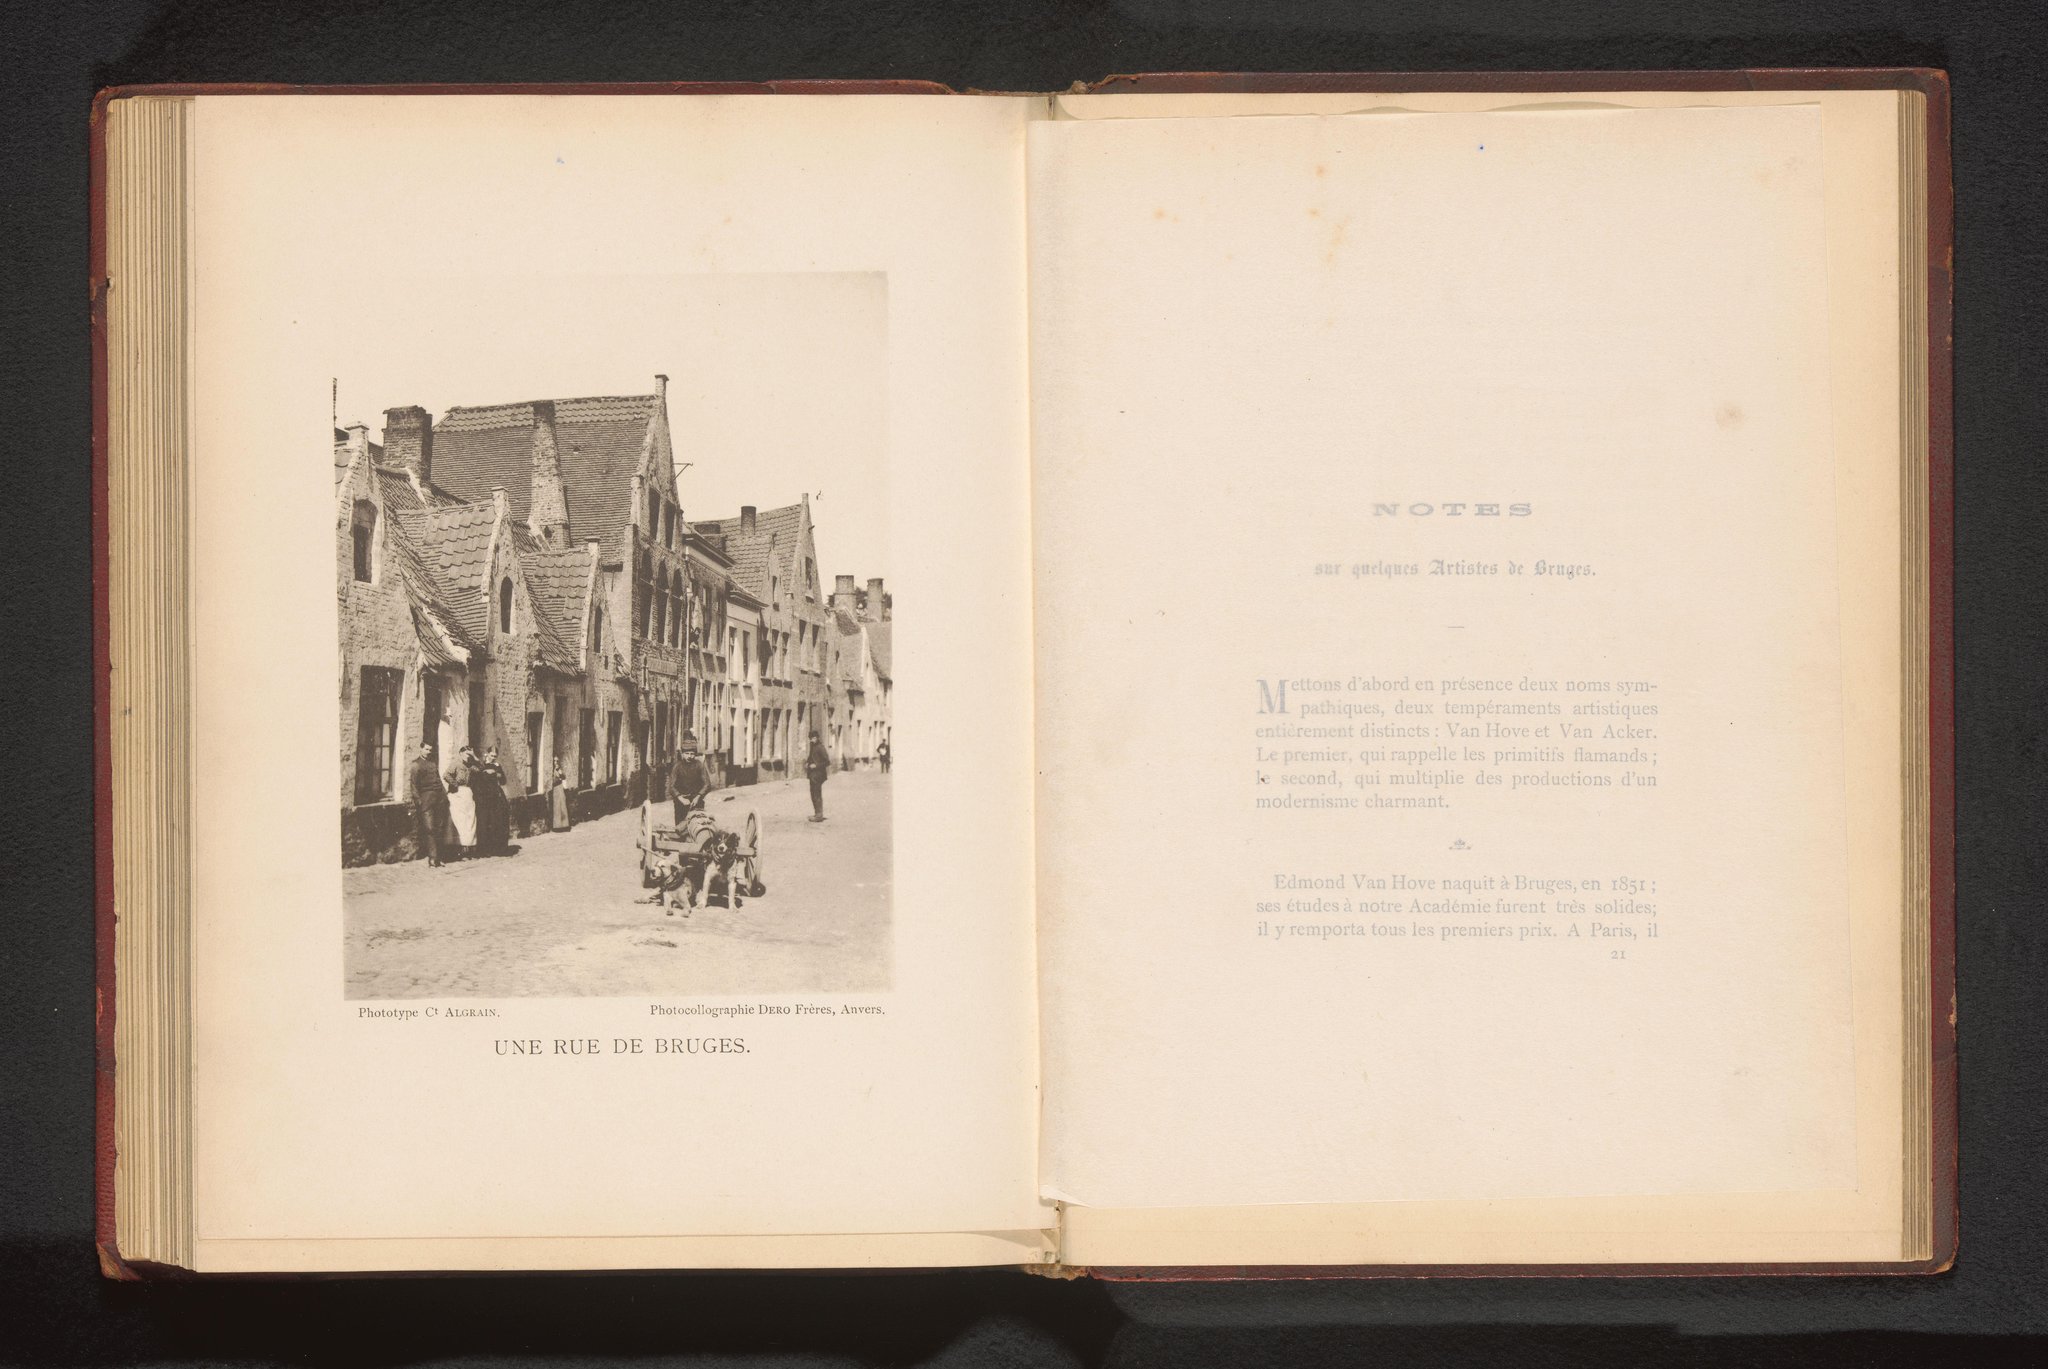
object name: page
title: Une Rue de Bruges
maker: alfred algrain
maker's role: fotograaf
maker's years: -1917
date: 1888-1893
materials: paper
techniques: photograph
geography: bruges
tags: adult man, street, dog, bruges